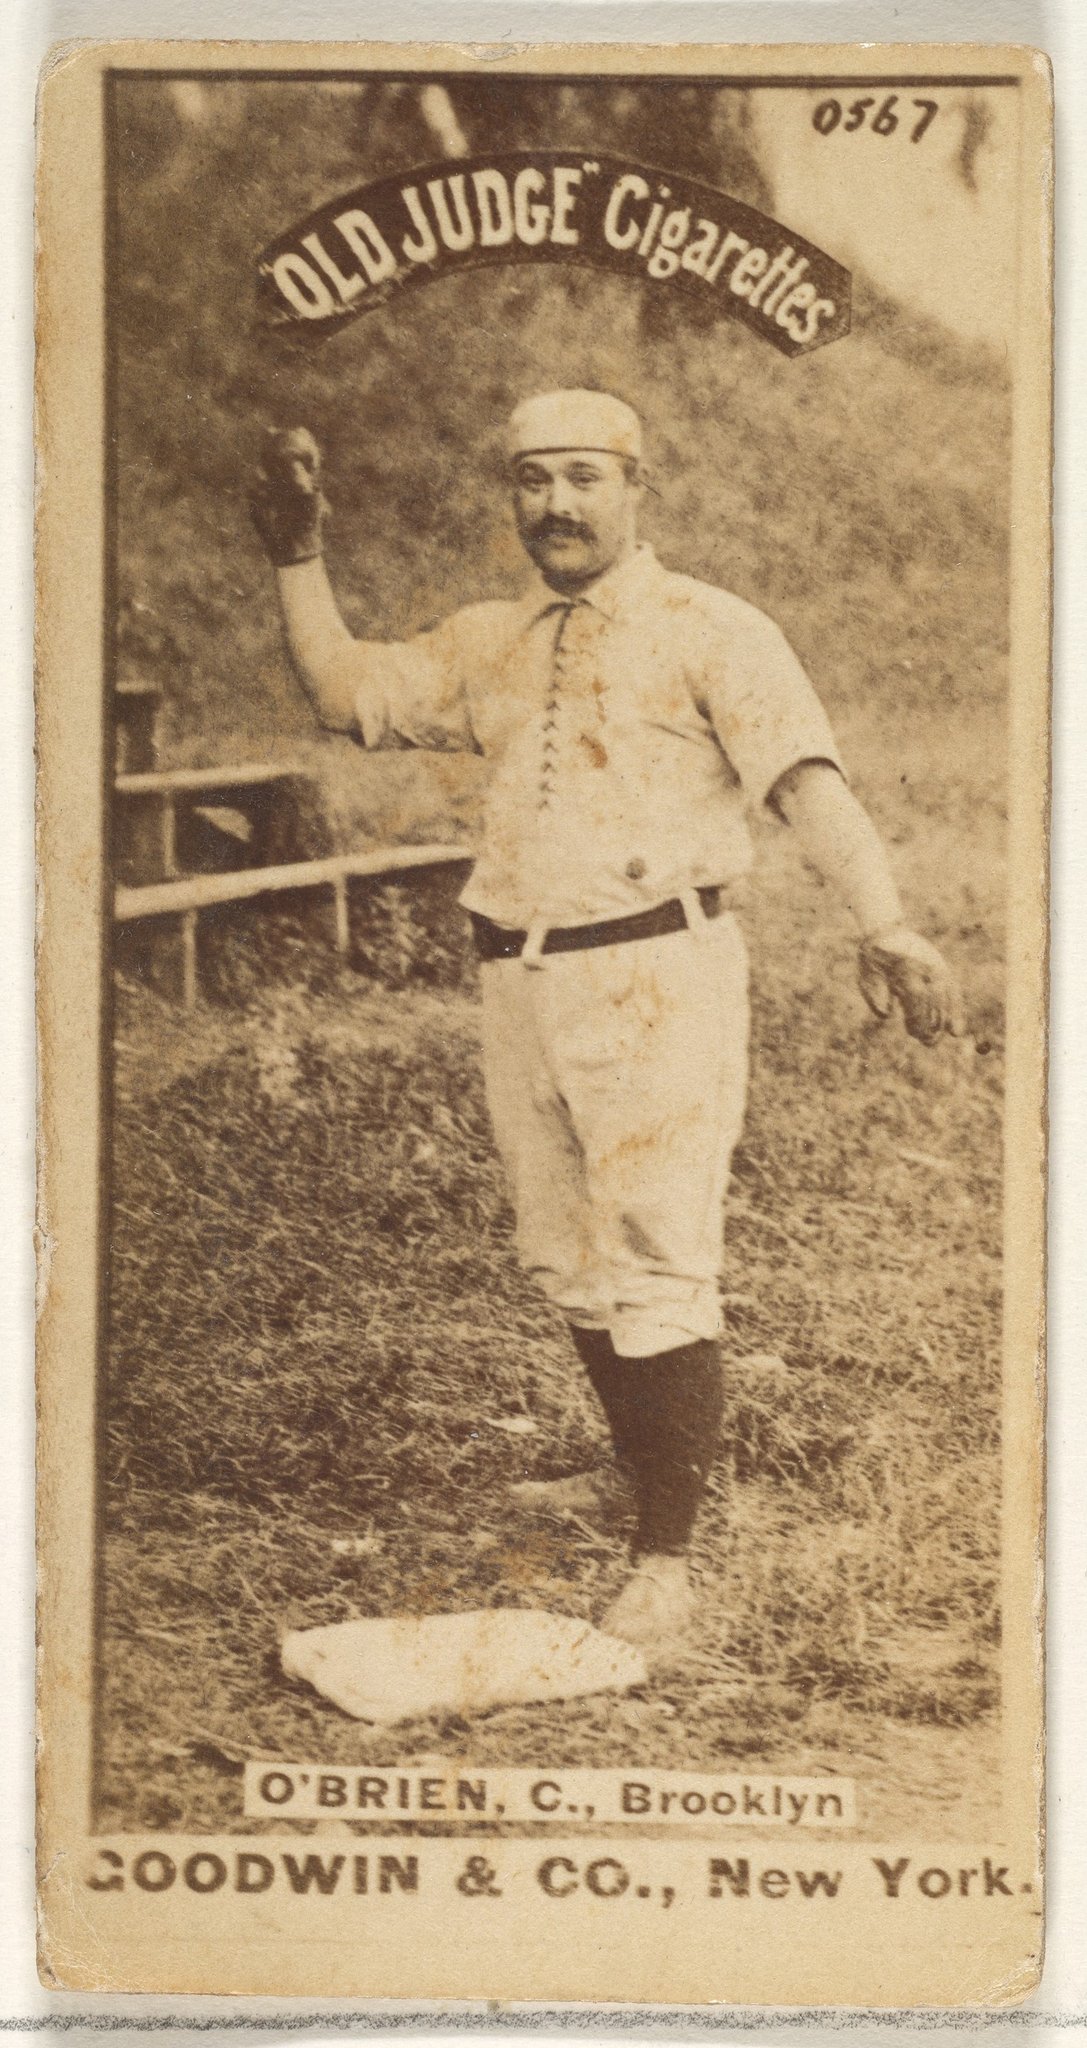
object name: baseball card, photograph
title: O'Brien, Catcher, Brooklyn, from the Old Judge series (N172) for Old Judge Cigarettes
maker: goodwin & company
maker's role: publisher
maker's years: 1850-1950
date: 1887-1890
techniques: albumen silver print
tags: men,portraits,baseball,athletes